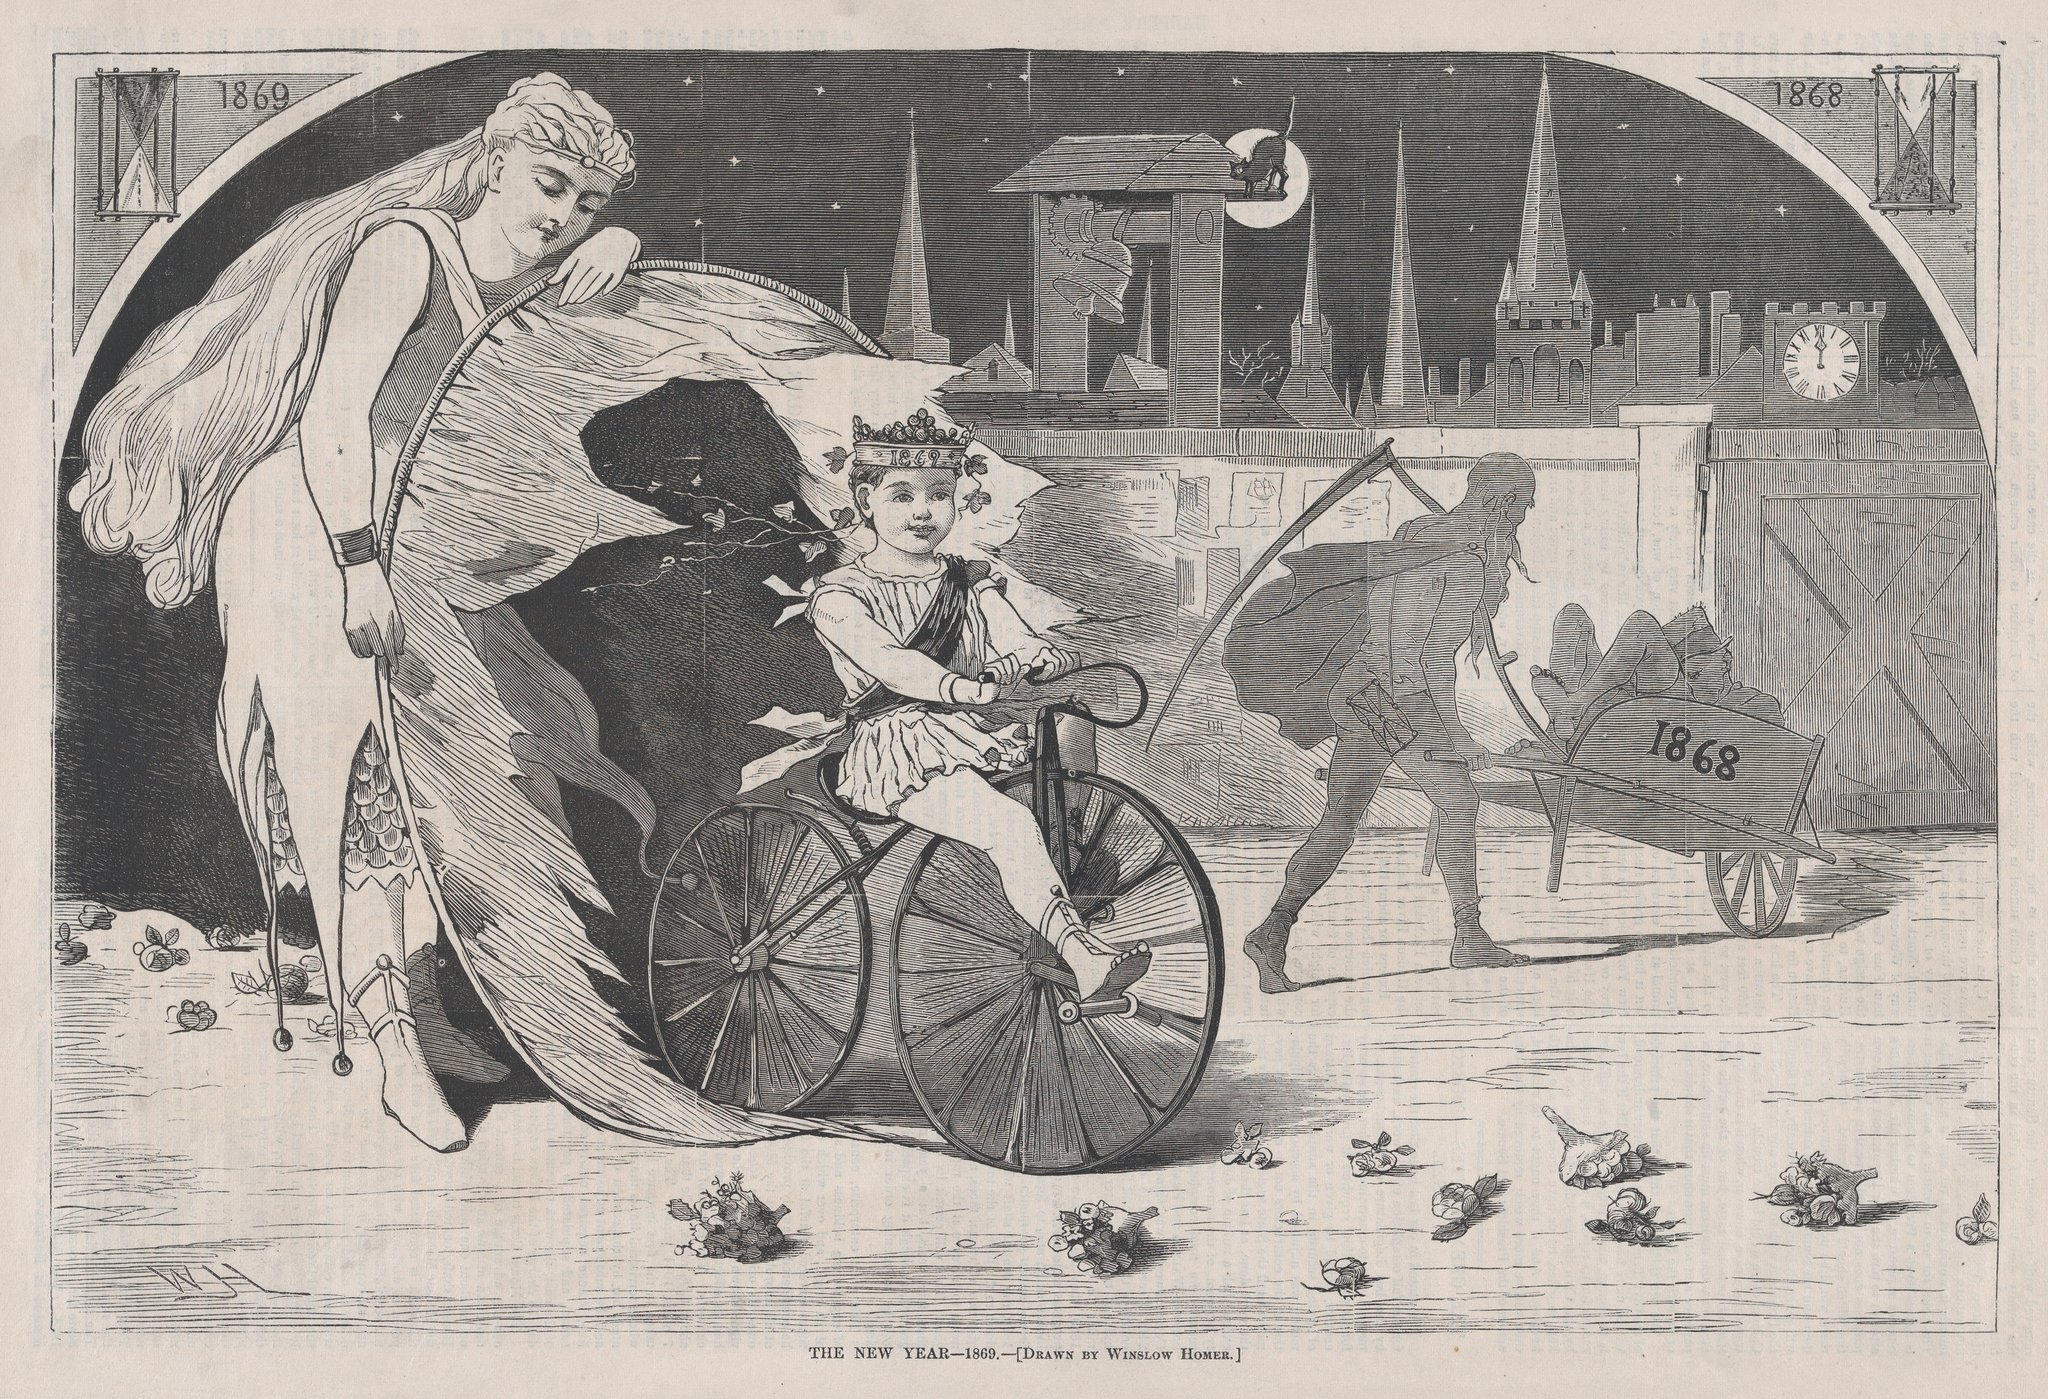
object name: print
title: The New Year – 1869 – Drawn by Winslow Homer (from "Harper's Weekly," Vol. XIII)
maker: winslow homer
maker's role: artist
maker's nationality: american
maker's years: 1836-1910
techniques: engraving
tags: children,women,cats,bicycles